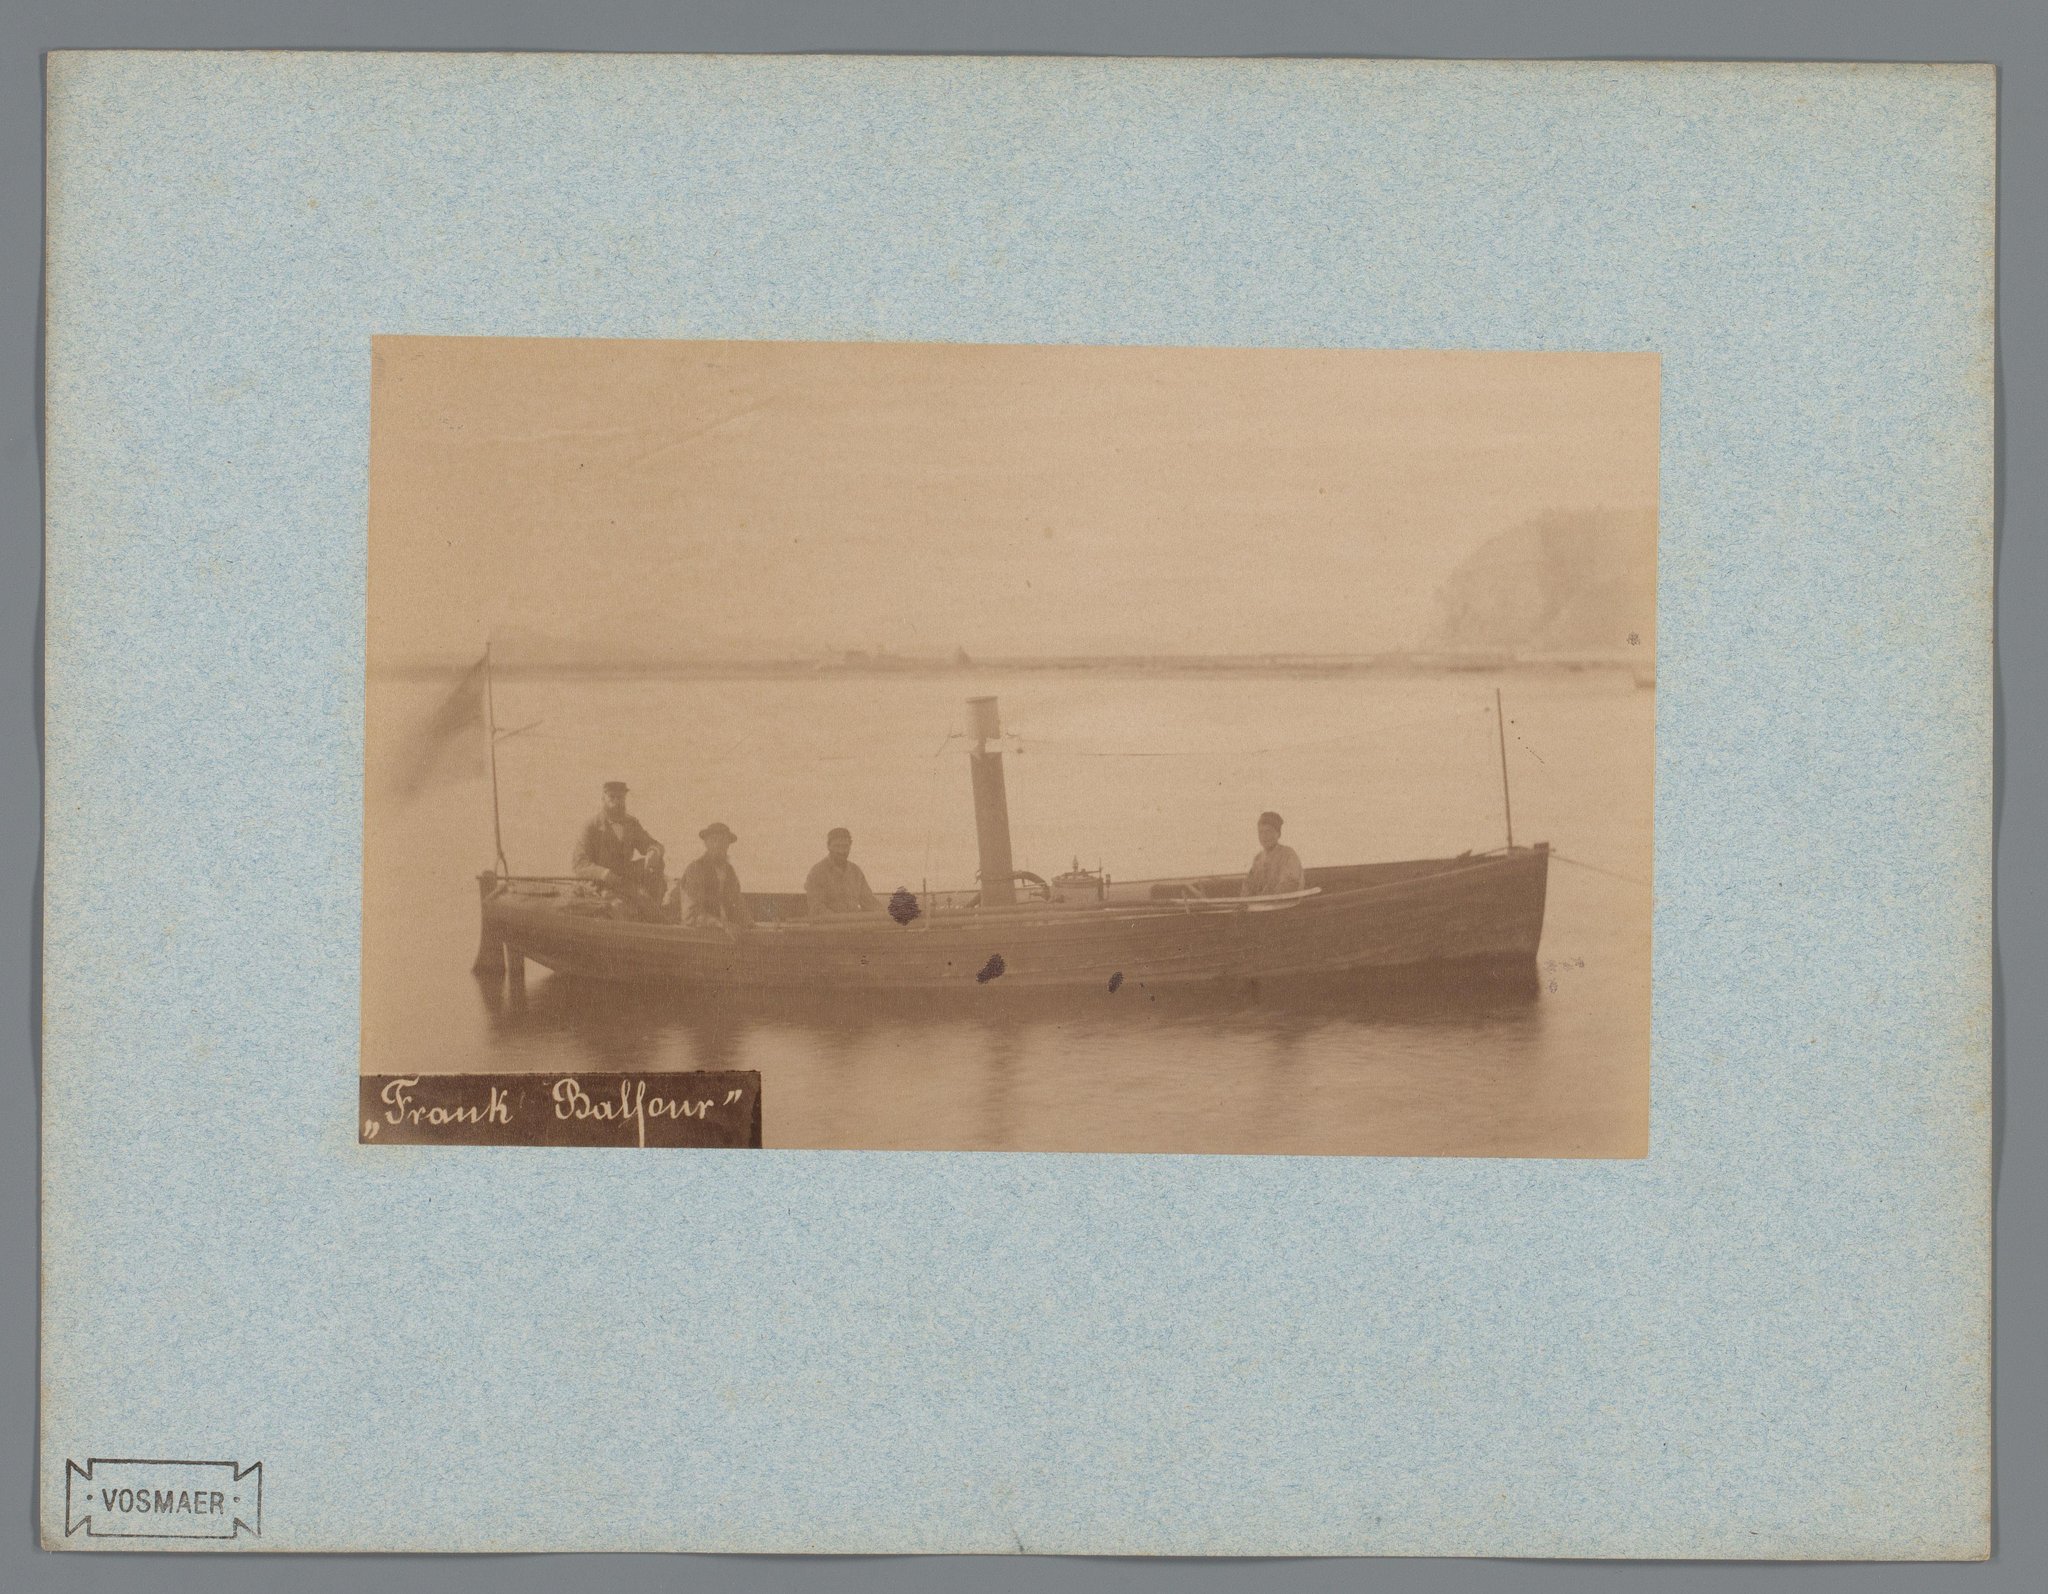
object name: photograph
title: Vier mannen in een boot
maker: Anonymous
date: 1872-1900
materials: cardboard, paper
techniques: albumen print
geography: naples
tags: ships (in general)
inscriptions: collector's mark: ‘VOSMAER’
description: Boot is mogelijk vernoemd naar Francis Maitland Balfour, een Schots mariene bioloog werkzaam in Napels.